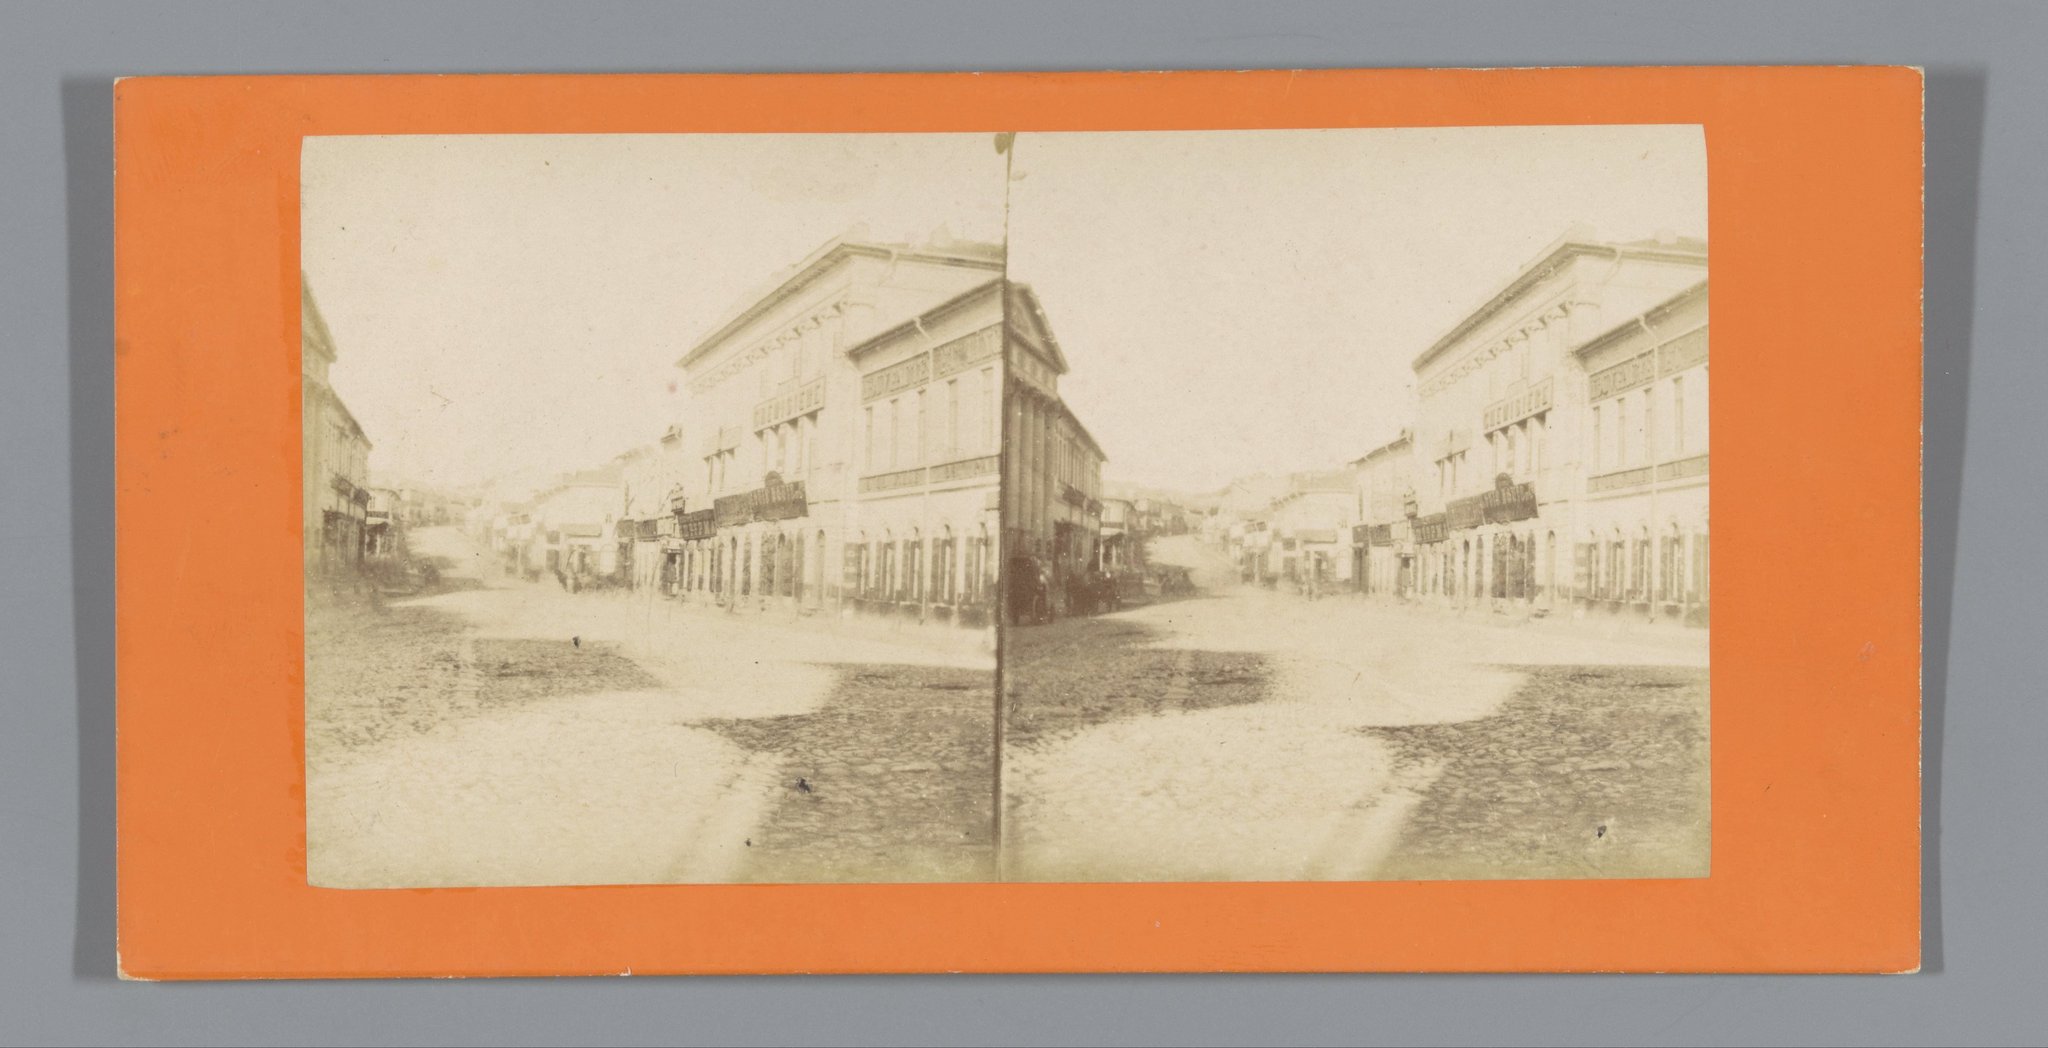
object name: stereograph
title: Gezicht op de Rue du pont des Marechaux in Moskou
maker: Anonymous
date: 1850-1880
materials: cardboard, photographic support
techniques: albumen print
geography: moscow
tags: street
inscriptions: inscription: ‘81 grande rue du pont des Marechaux Moscou’